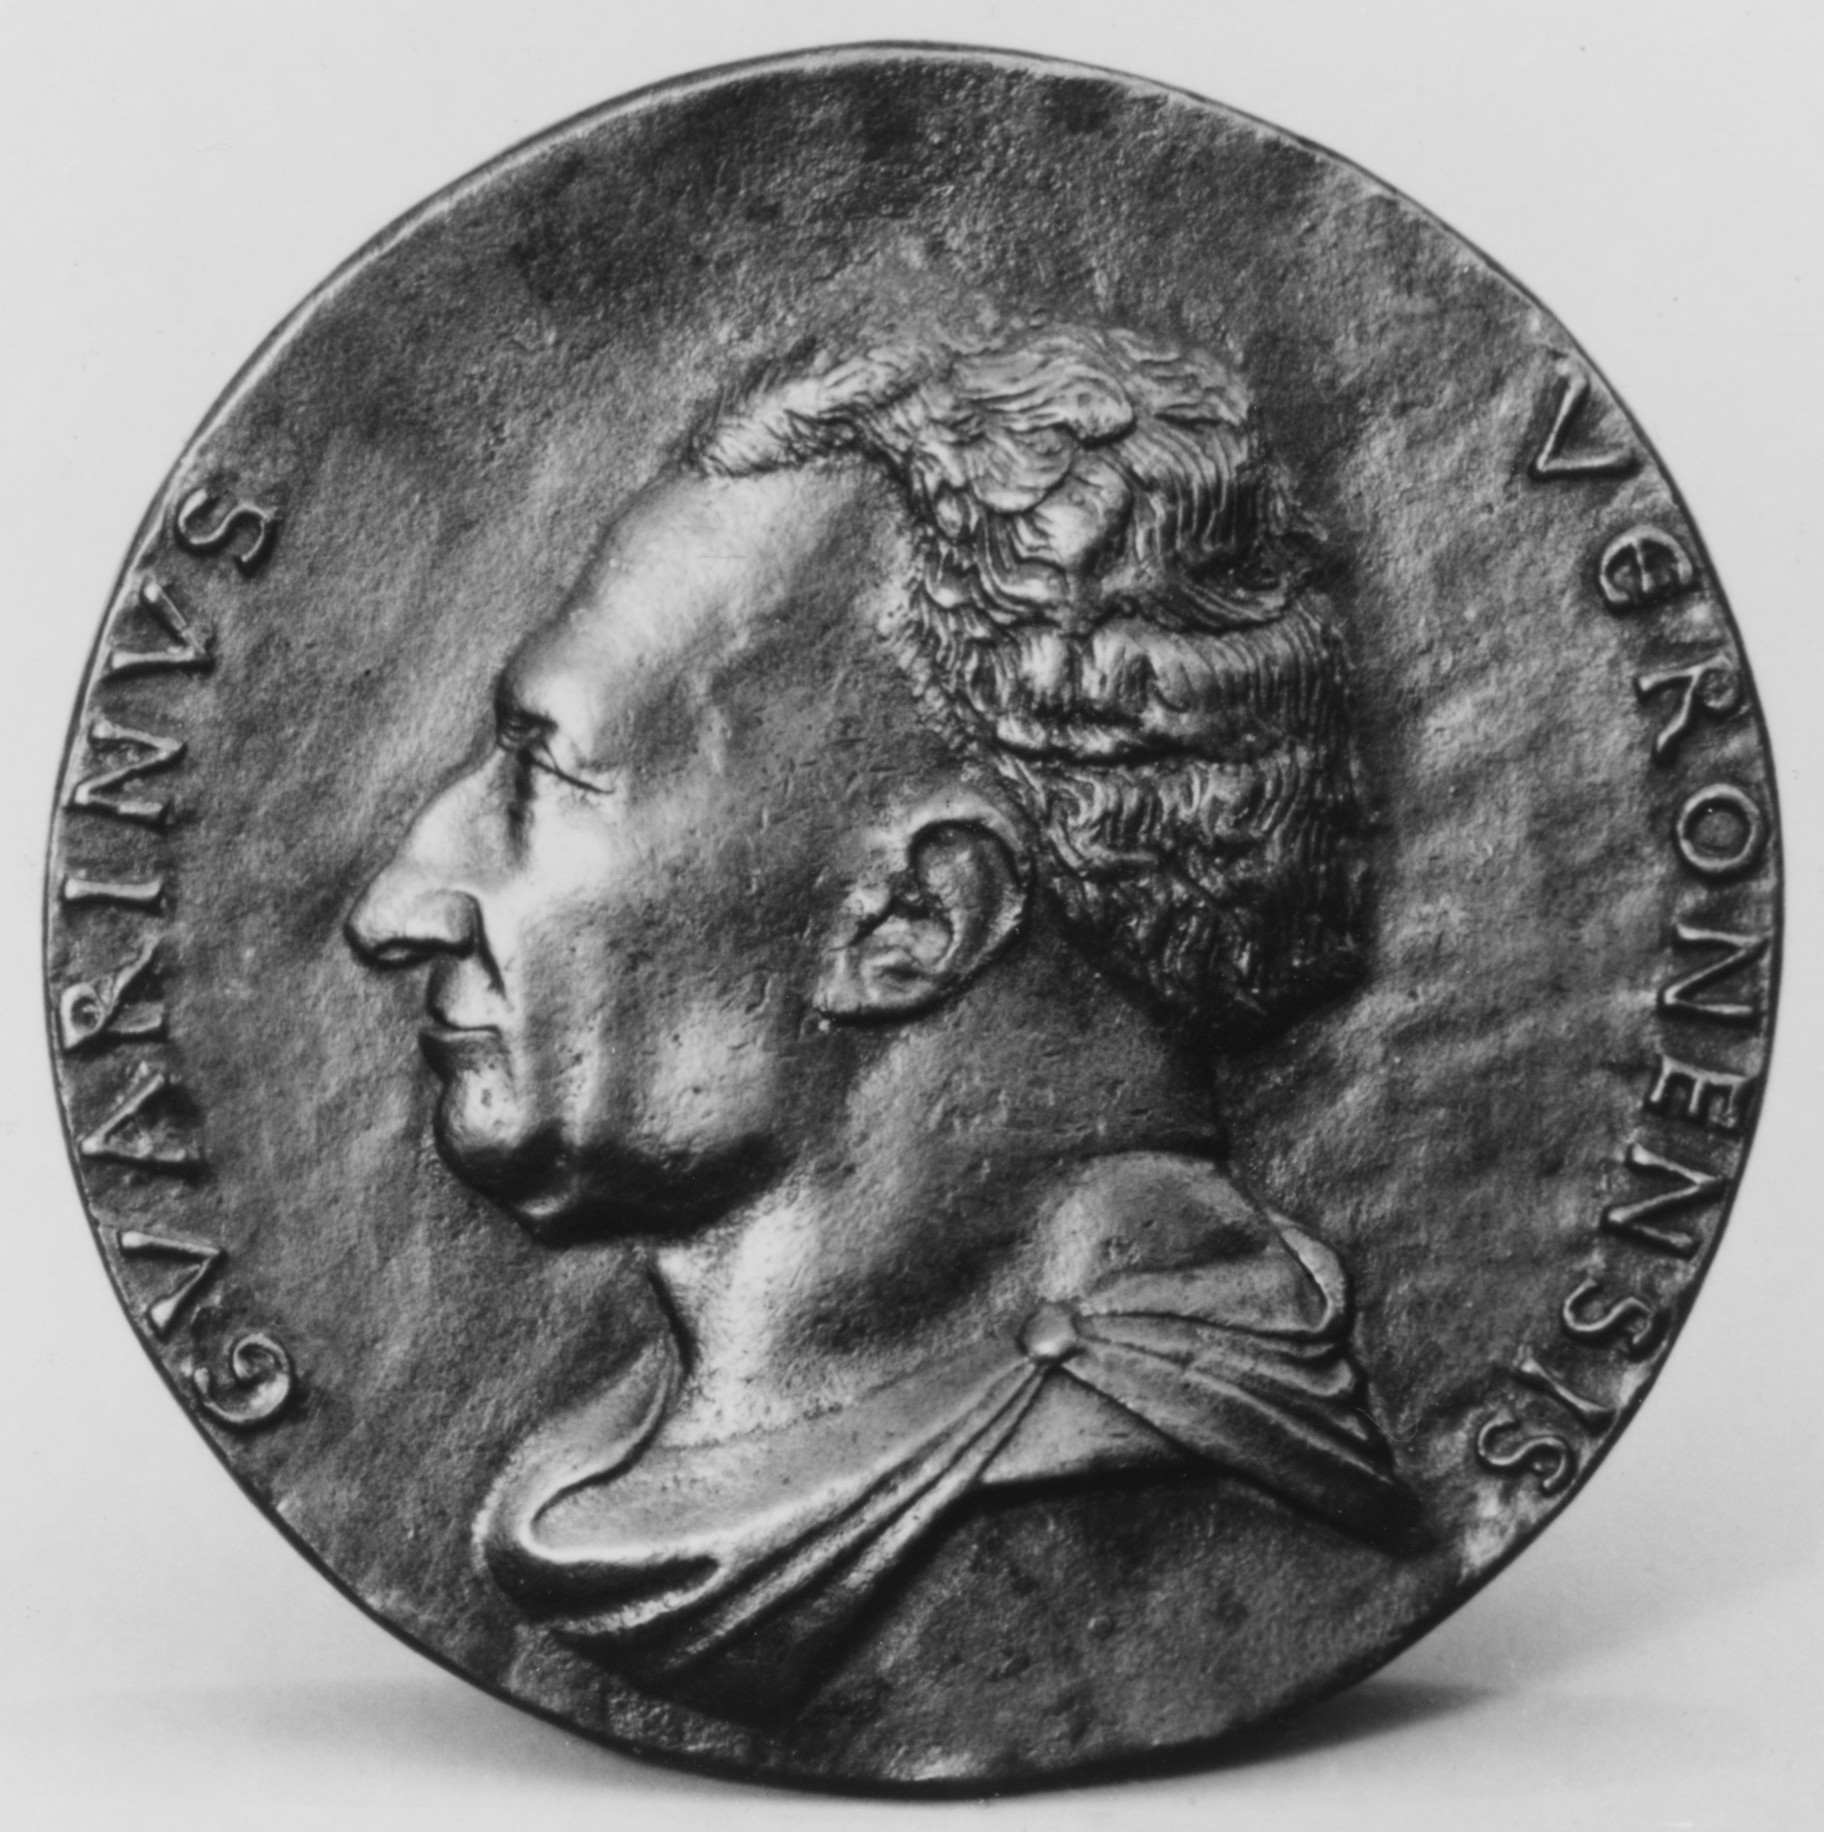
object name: medal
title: Guarino da Verona, Humanist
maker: matteo de' pasti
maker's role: artist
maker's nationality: italian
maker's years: 1420-1467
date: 1441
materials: bronze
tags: men,profiles